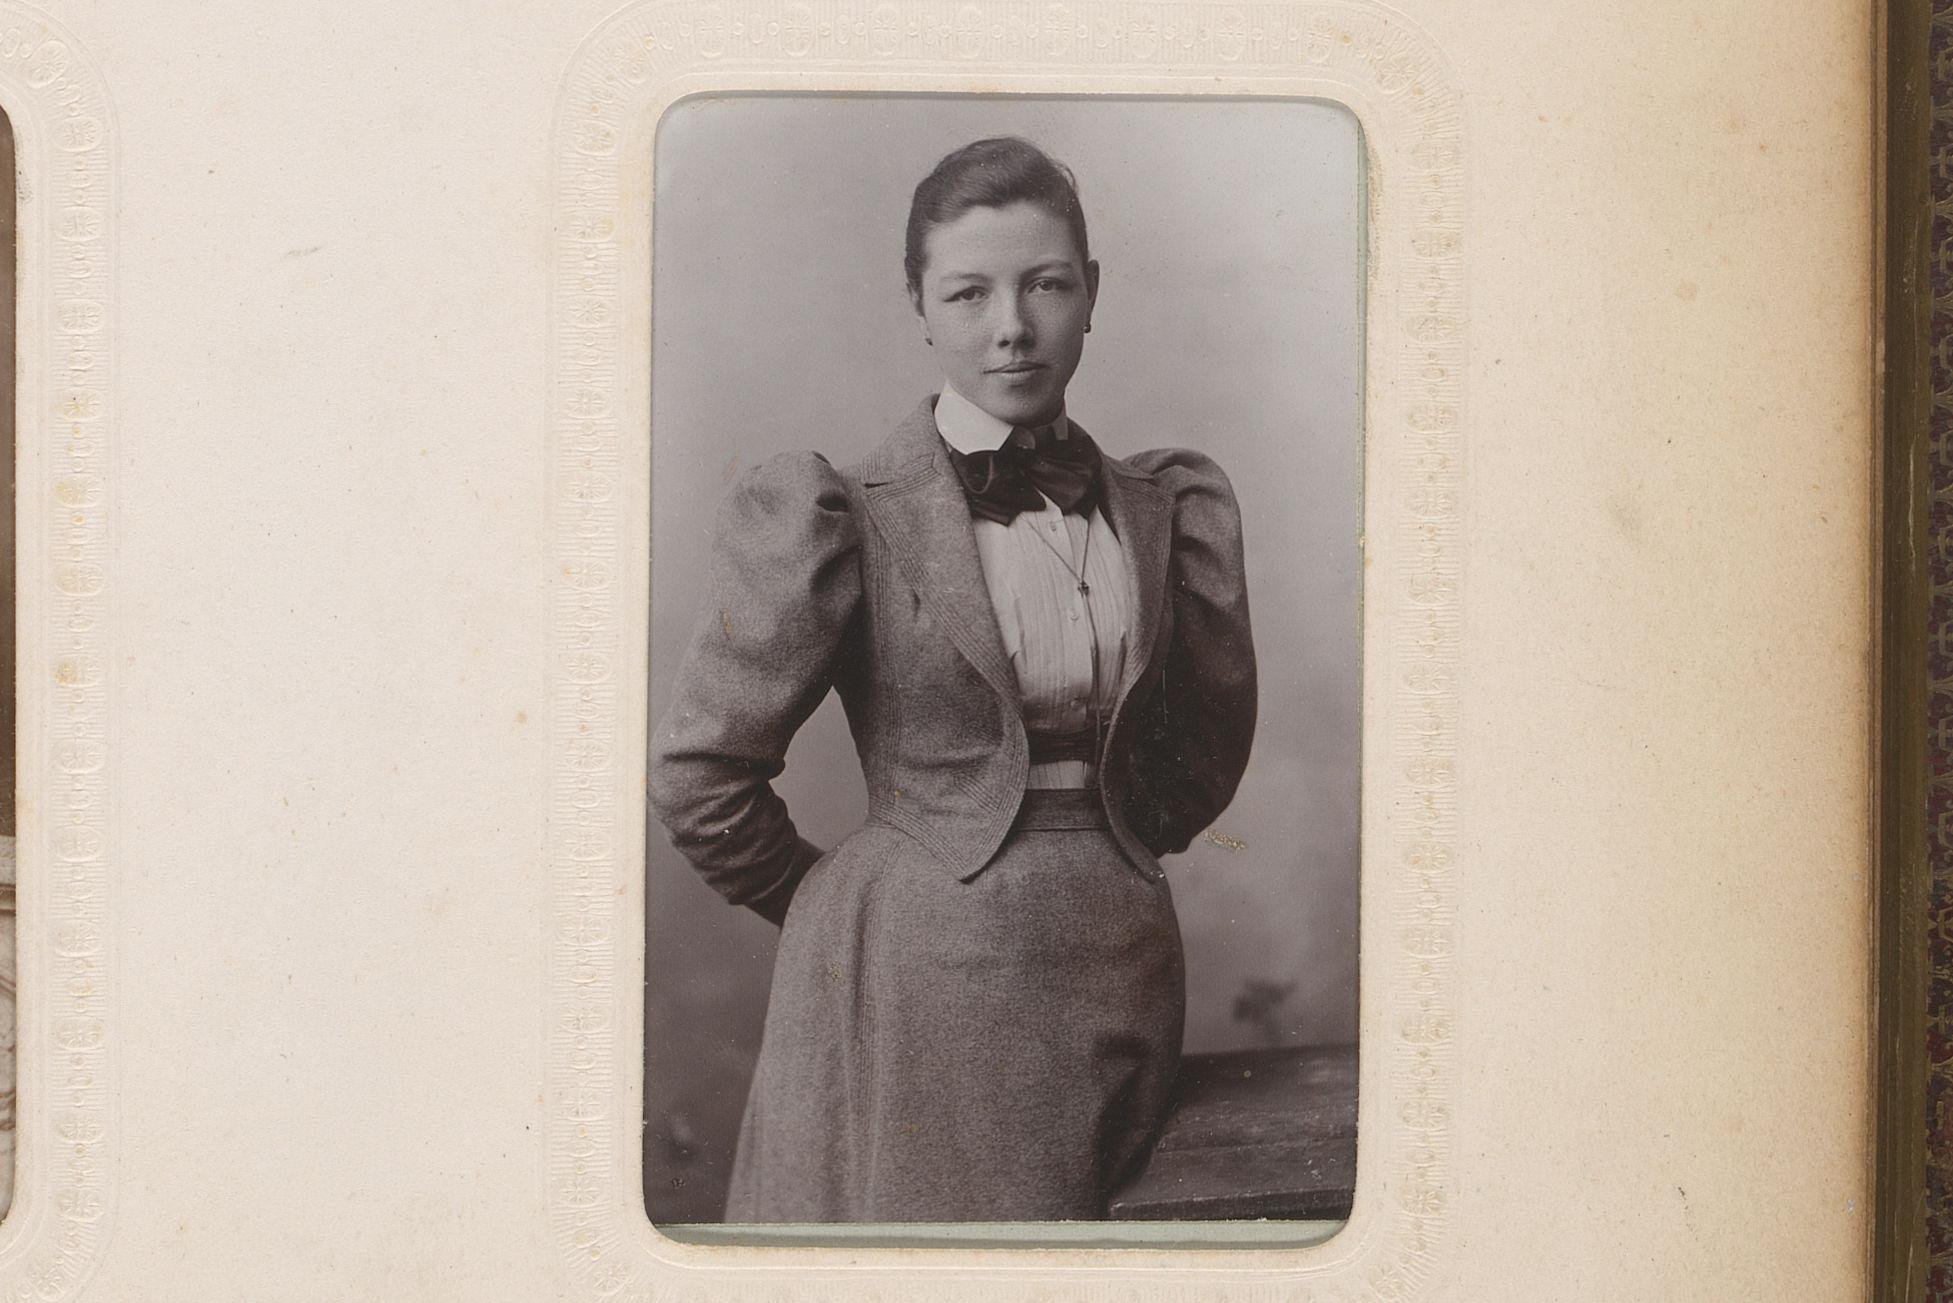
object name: album leaf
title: Portret van een staande jonge vrouw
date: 1891-1910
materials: cardboard, photographic support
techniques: collodion silver print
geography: amsterdam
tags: adolescent, young woman, maiden, historical persons - bb - woman, standing figure - aa - female human figure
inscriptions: inscription: ‘Photographisch Gezelschap Amsterdam’